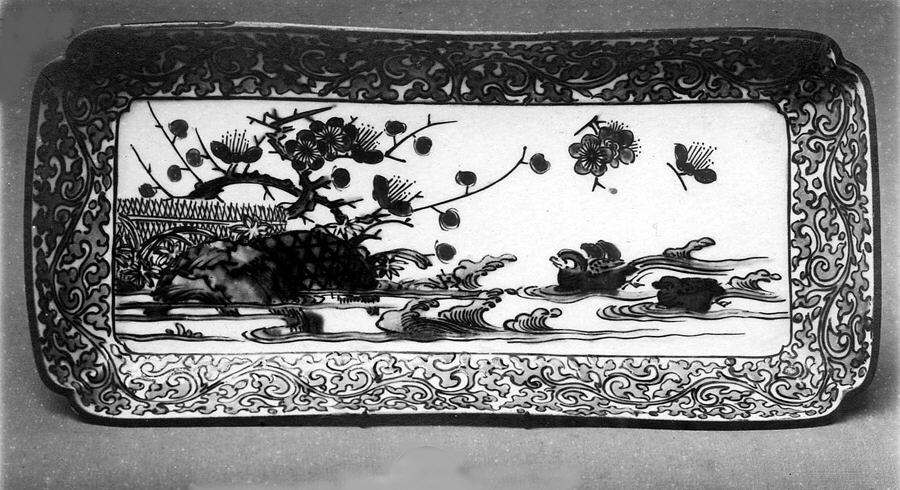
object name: tray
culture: japanese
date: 1720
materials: enamel, glaze, porcelain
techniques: polychrome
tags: flowers,trees